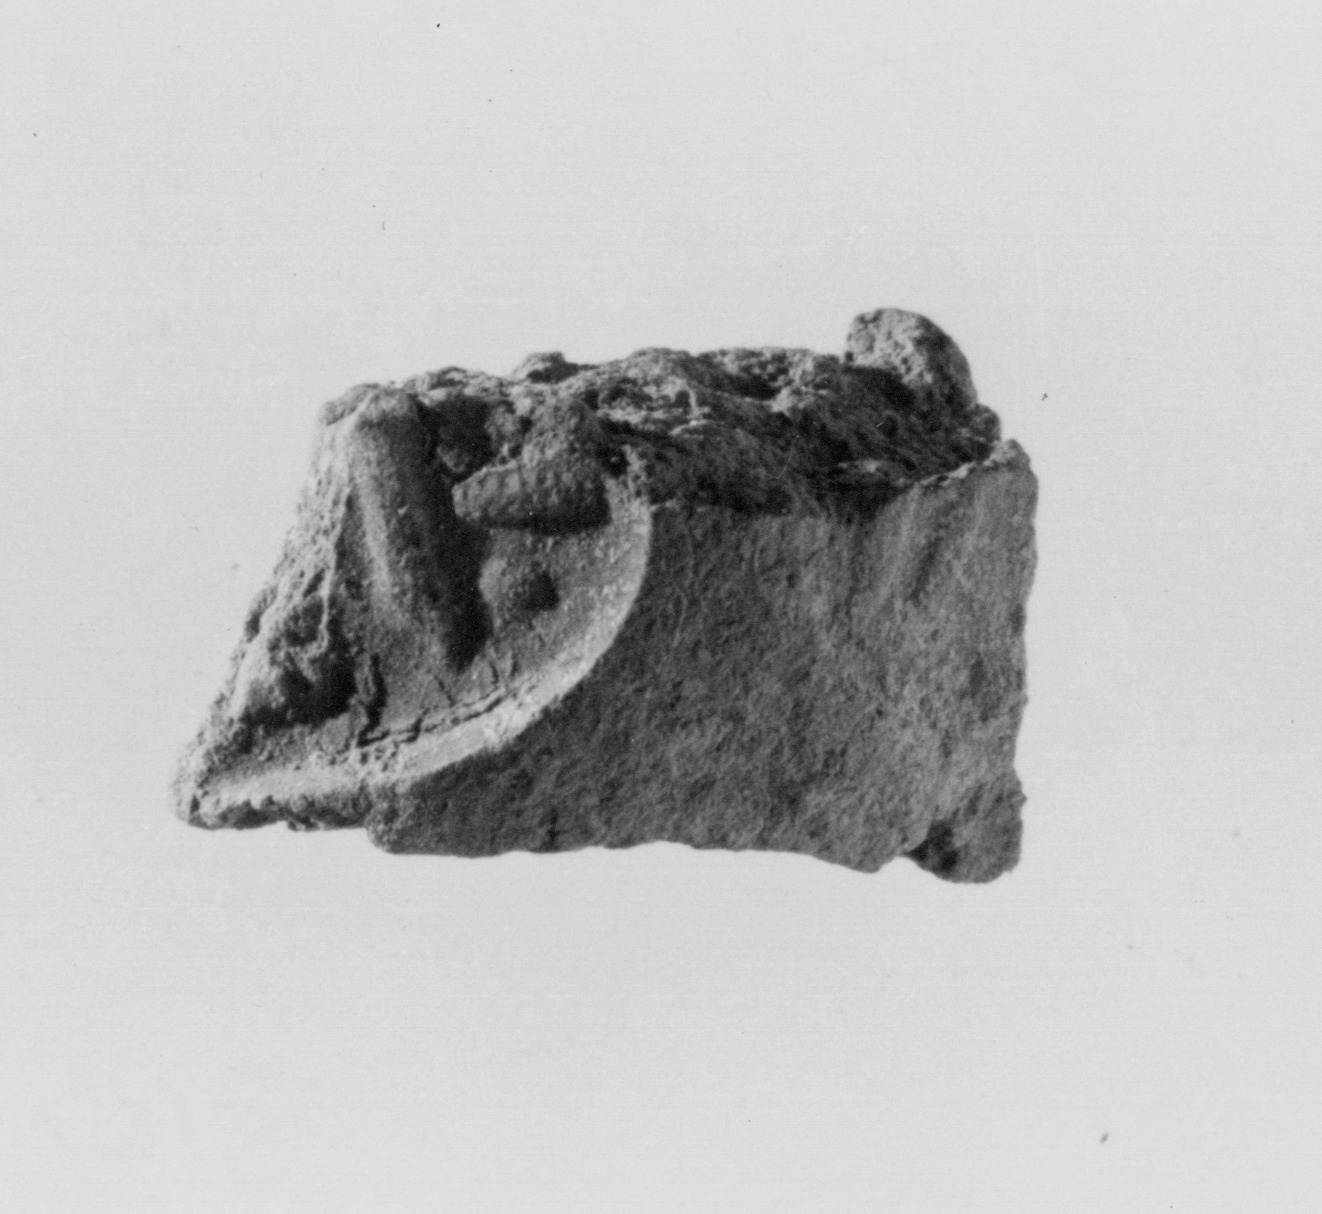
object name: sealing, nebmaatre, amenhotep iii, horus, re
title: Document Sealing With the Throne Name of Amenhotep III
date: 1390-1352 BCE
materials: mud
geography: egypt